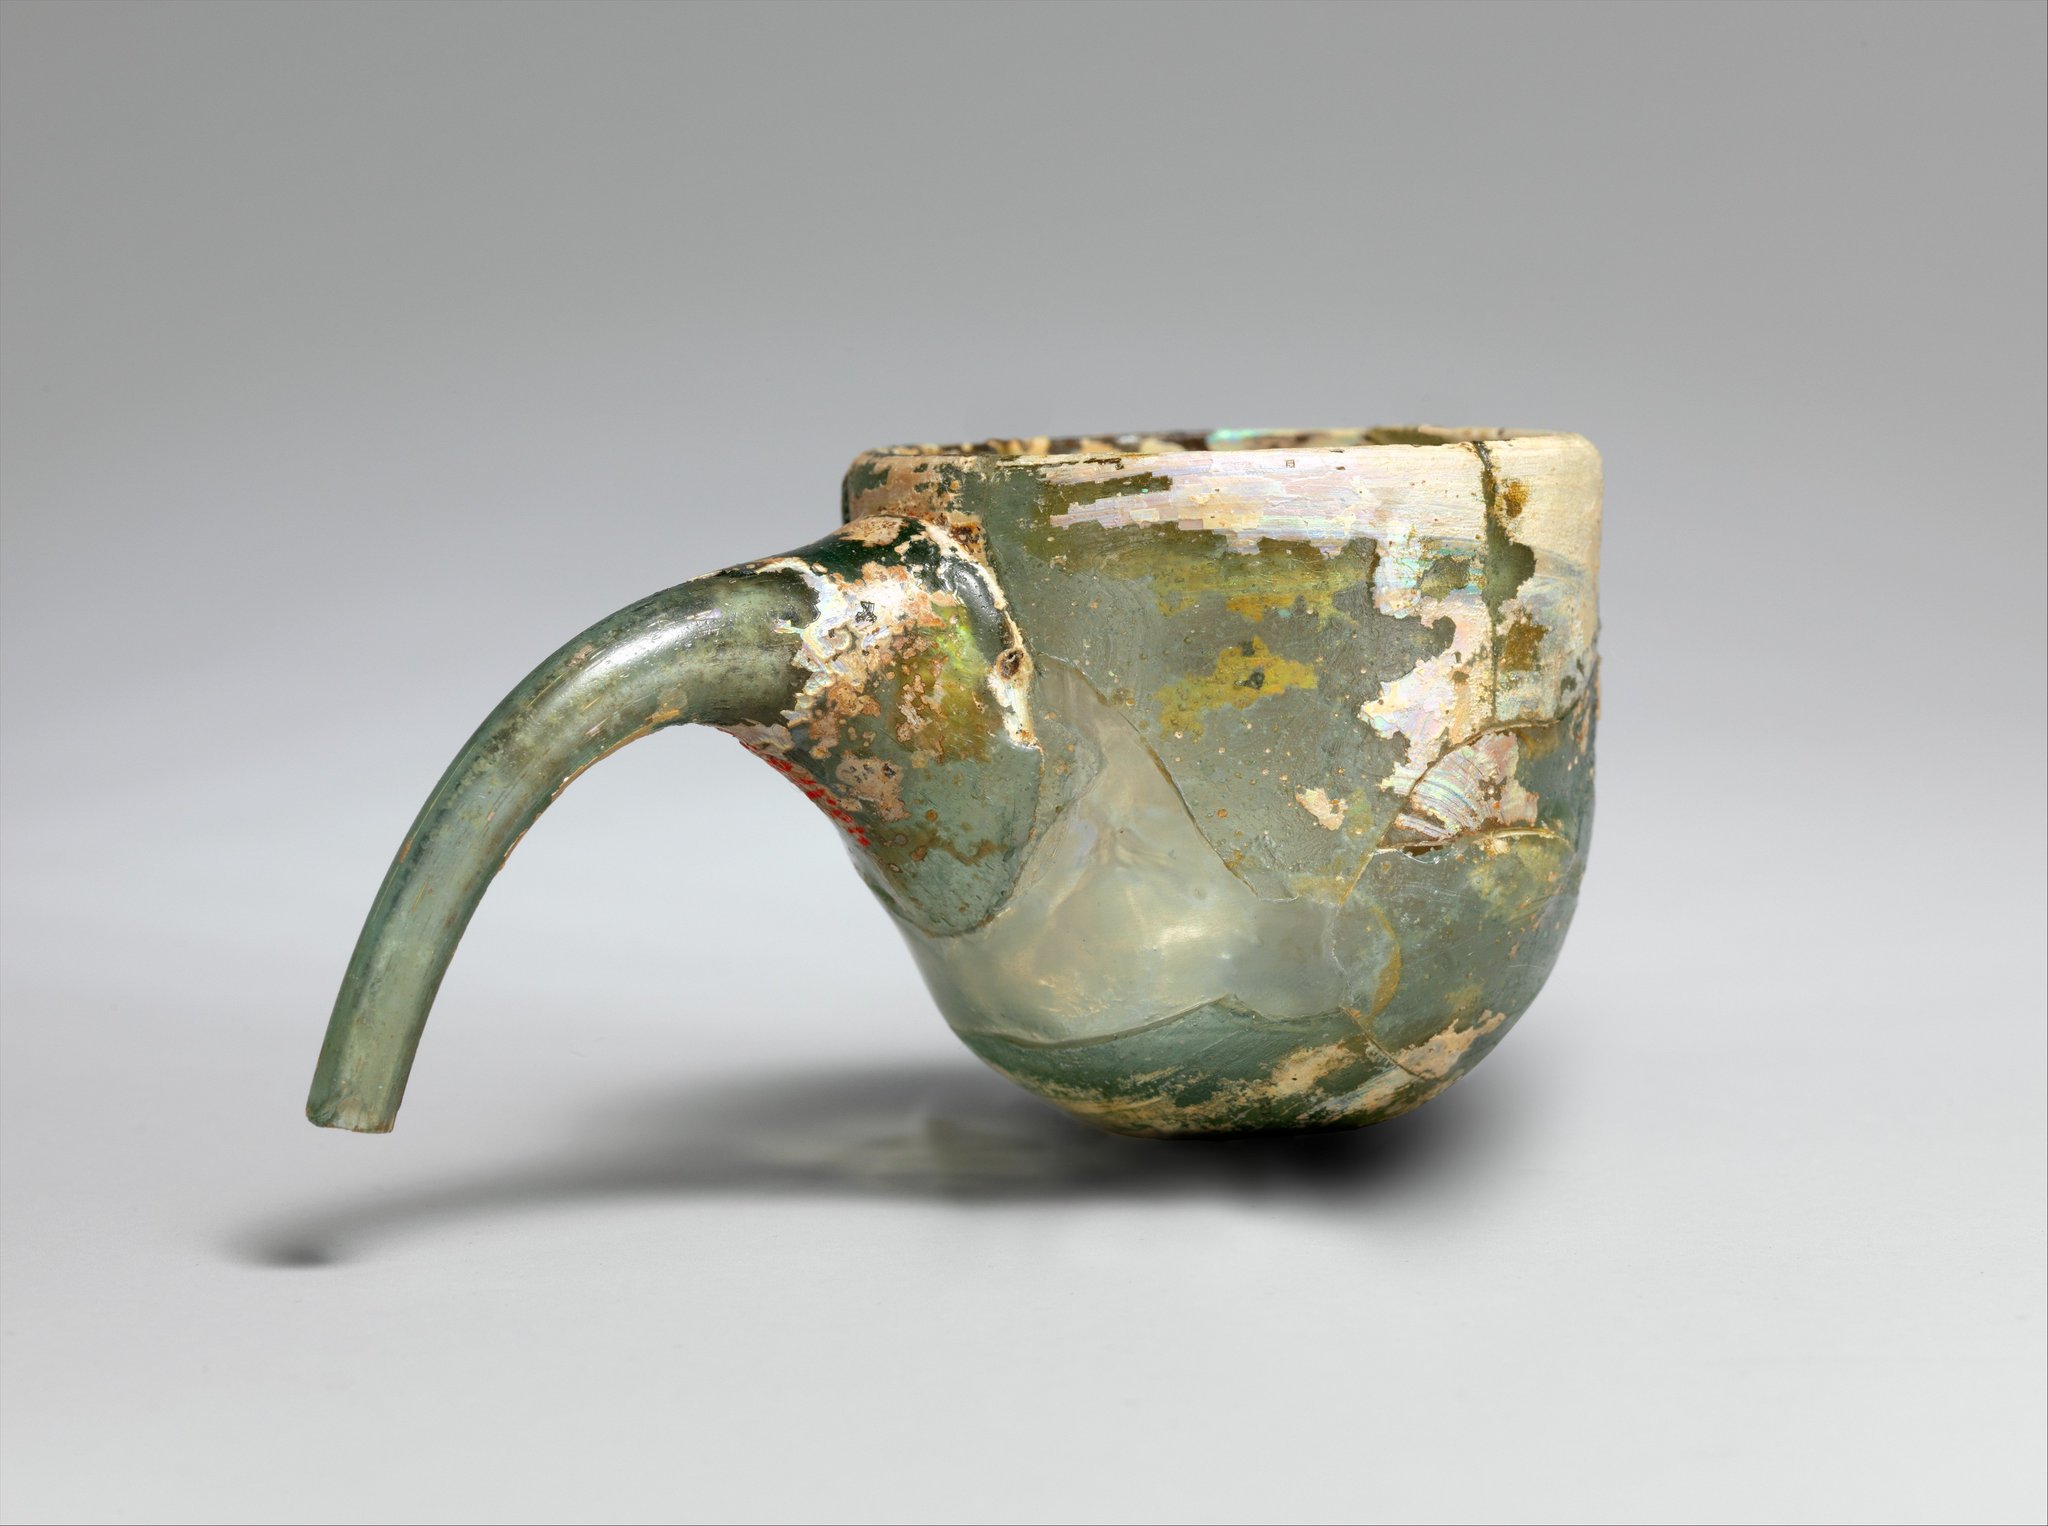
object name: alembic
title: Physician's Cupping Glass or Alembic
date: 801-1100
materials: glass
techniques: glassblowing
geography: iran